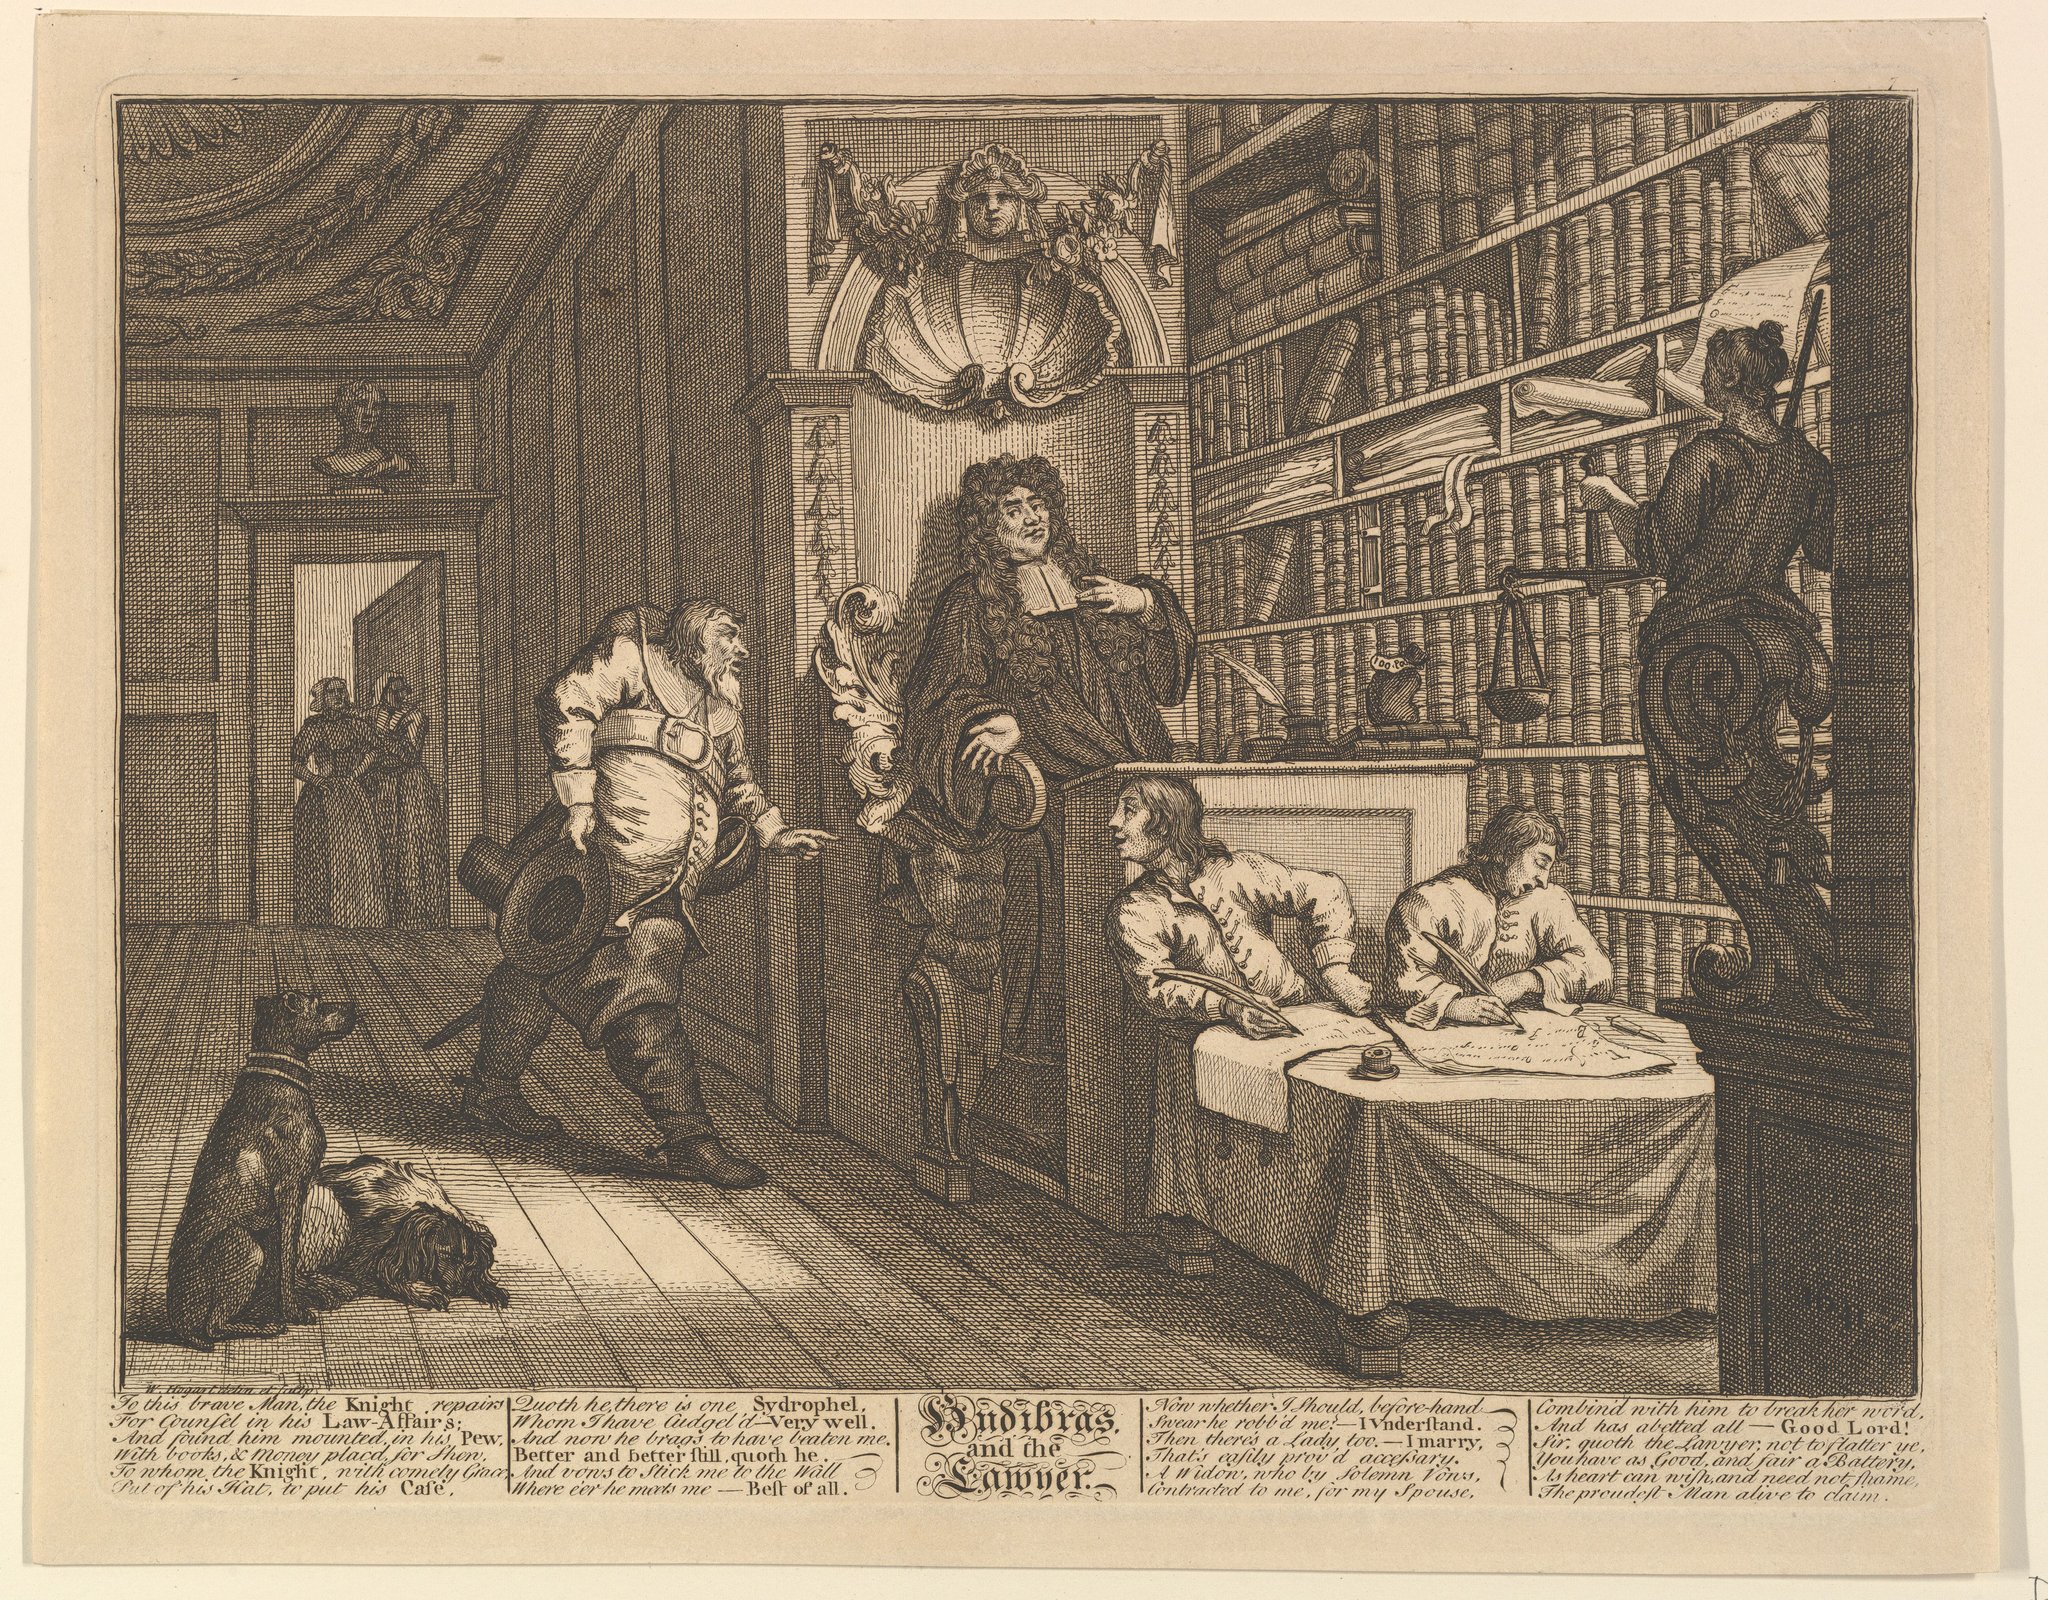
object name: print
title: Hudibras and the Lawyer (Twelve Large Illustrations for Samuel Butler's Hudibras, Plate 12)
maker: william hogarth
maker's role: artist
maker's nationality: british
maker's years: 1697-1764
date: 1725-1768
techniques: engraving, etching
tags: books,interiors,men,women,dogs,law